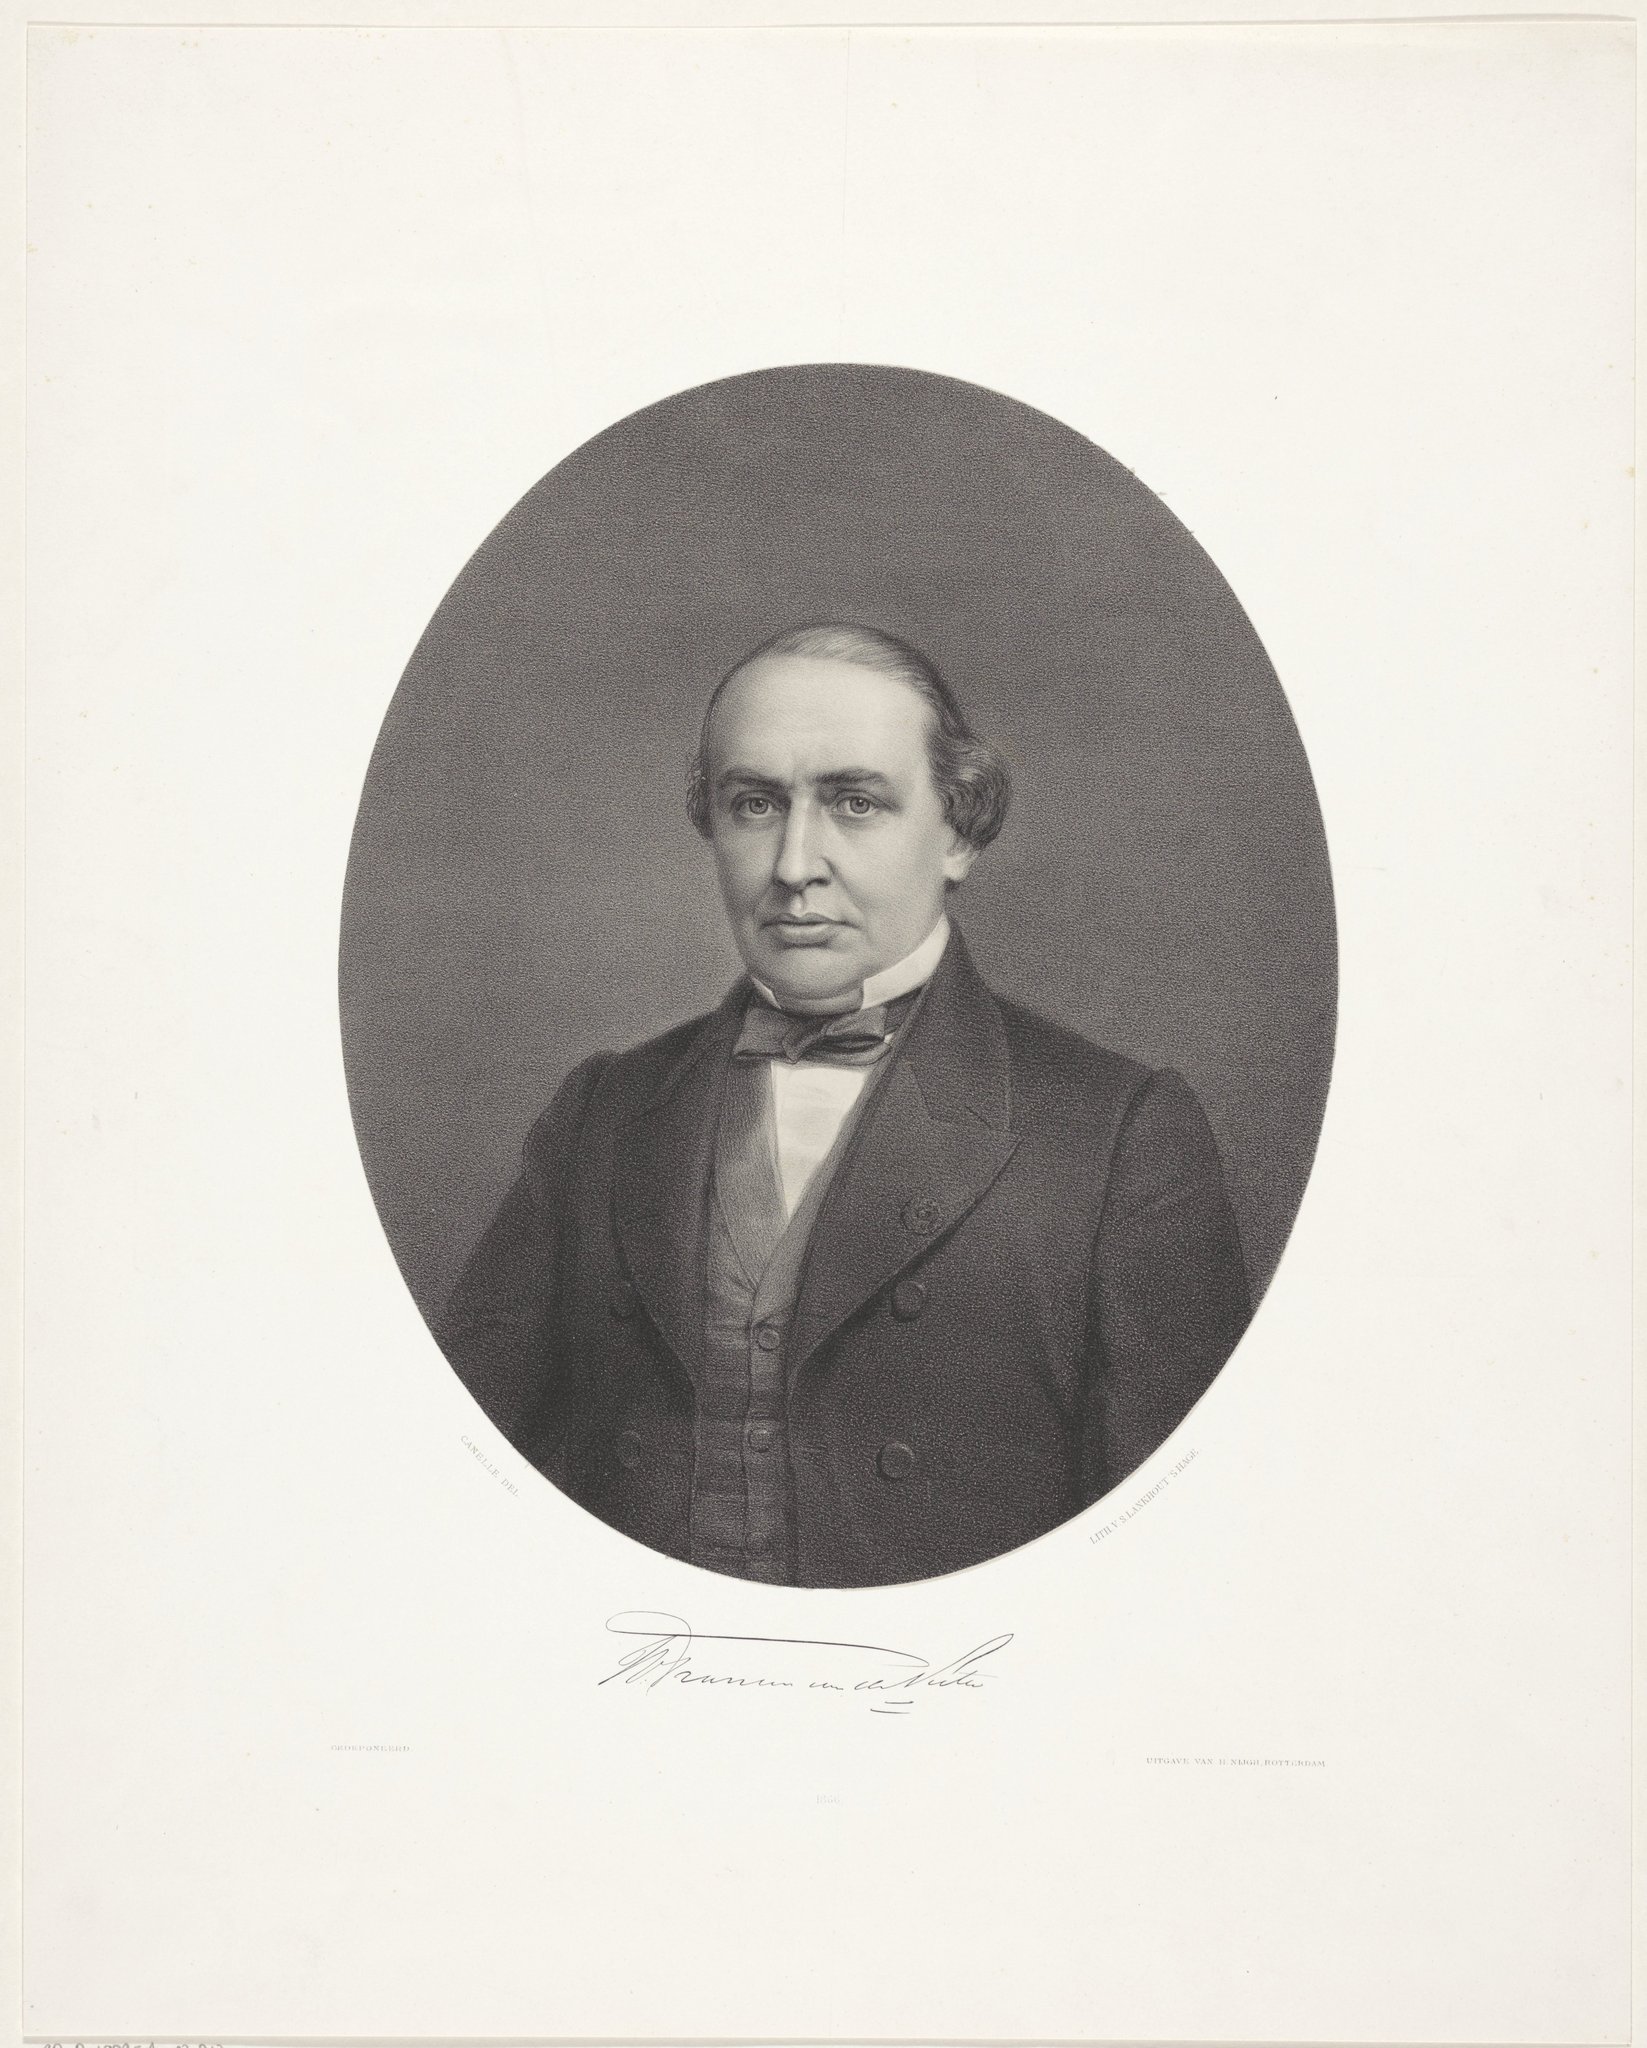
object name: print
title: Portret van Isaäc Dignus Fransen van de Putte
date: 1866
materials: paper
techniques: lithograph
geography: the hague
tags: politician, historical persons (+ head (and shoulders) (portrait))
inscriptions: collector's mark: Lugt 2228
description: De geportretteerde is afgebeeld in een ovaal. Onder het portret zijn signatuur.